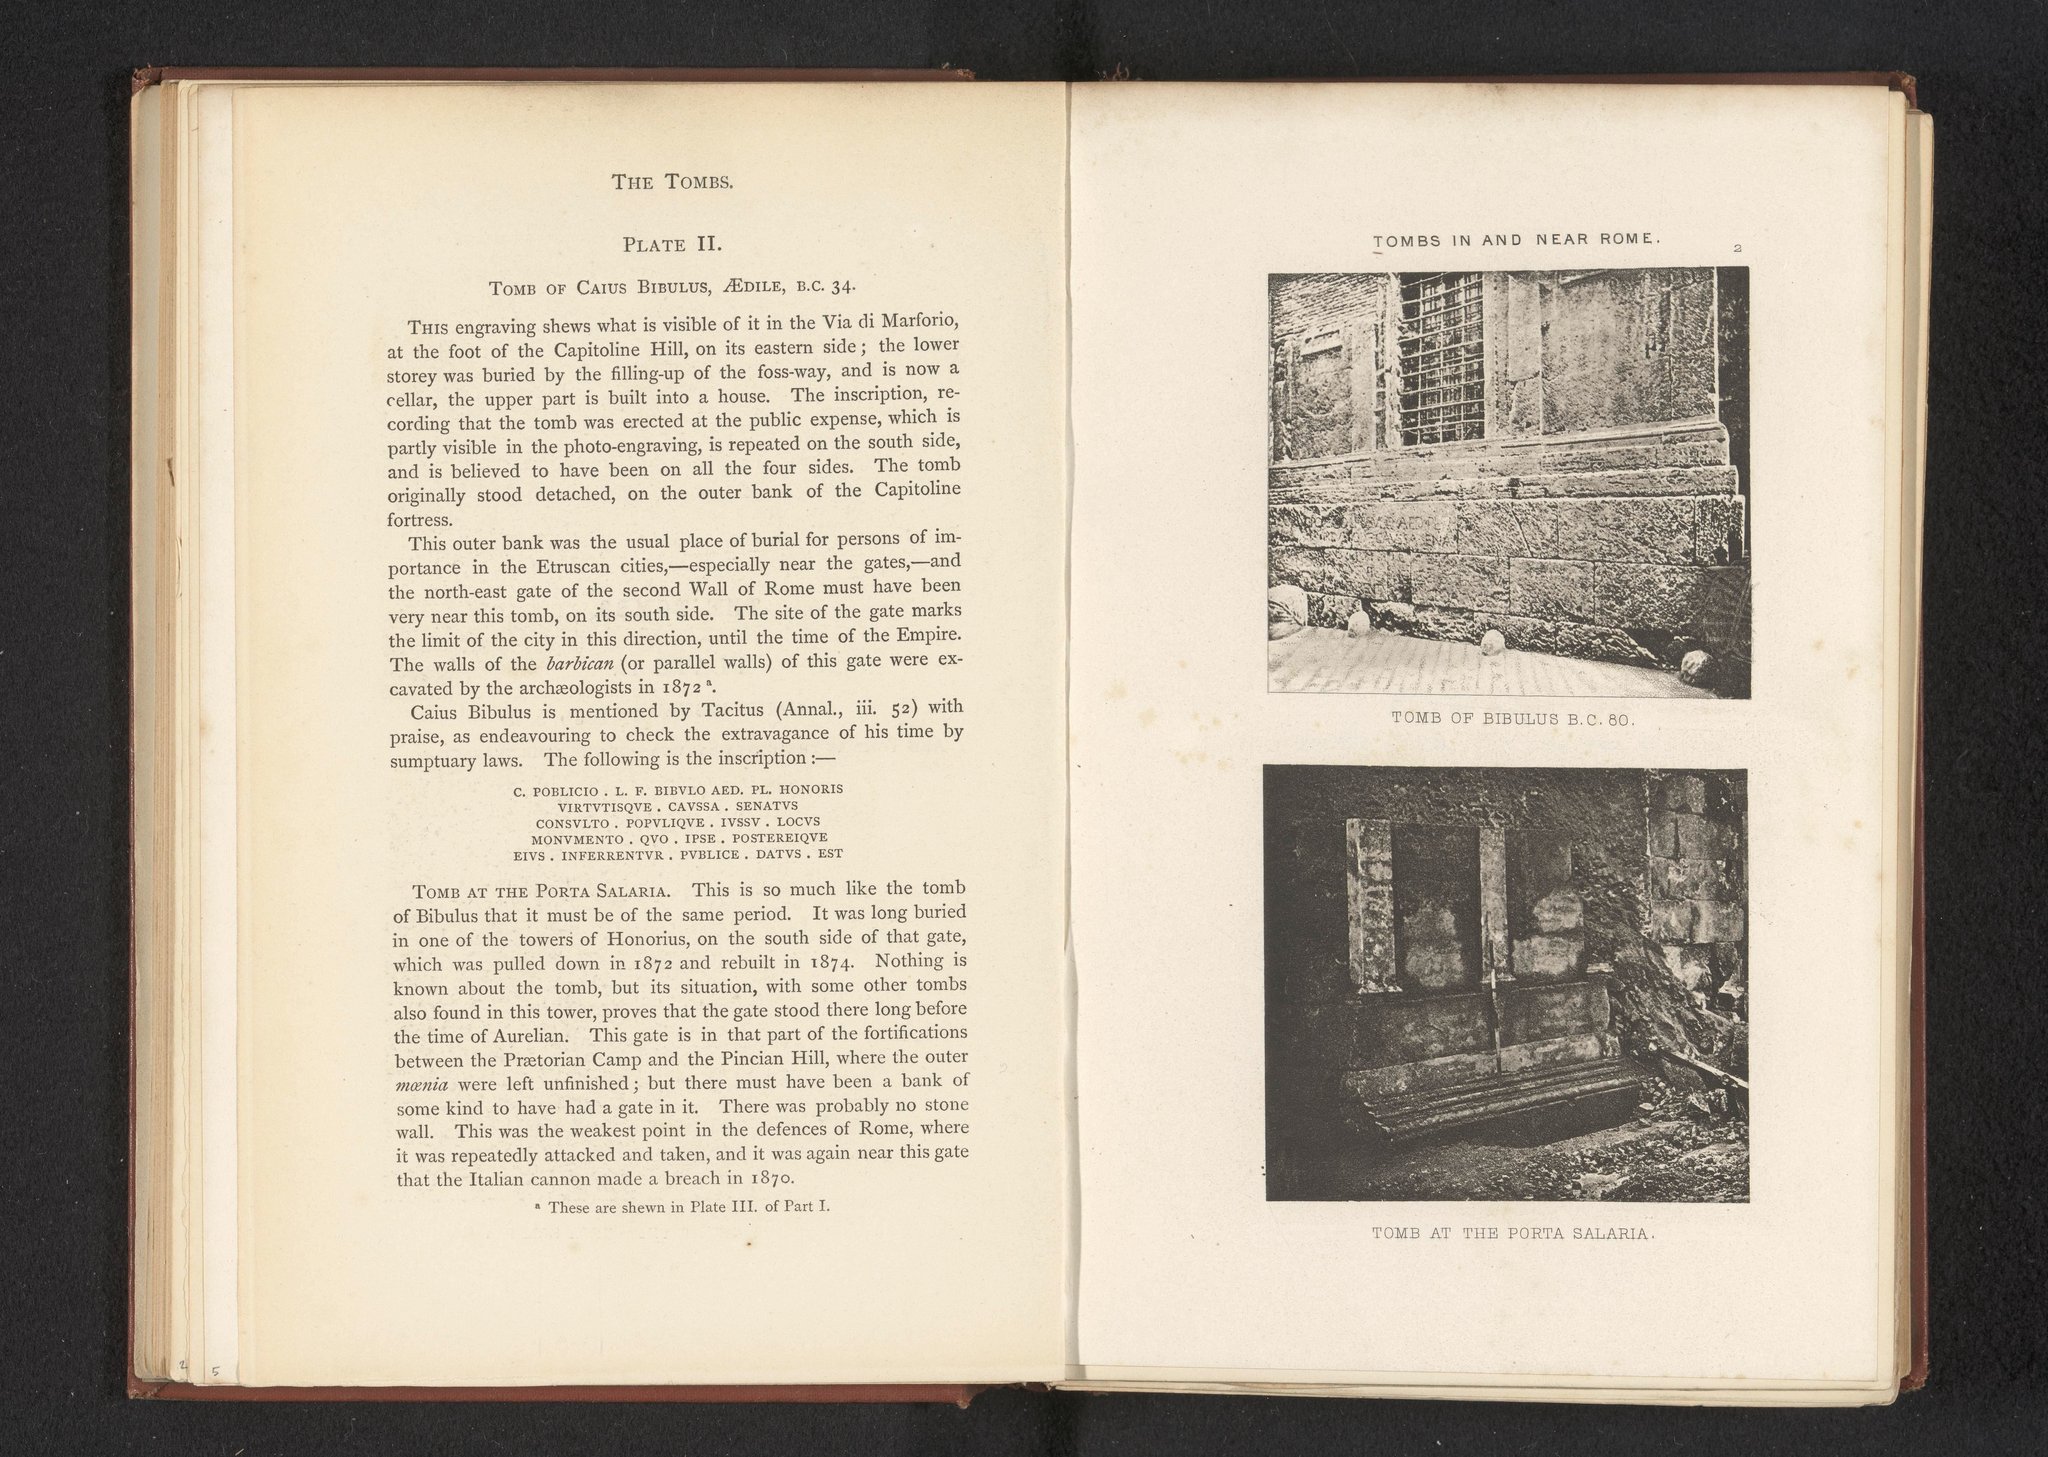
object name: photomechanical print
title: Tomb of Bibulus B.C. 80. Tomb at the Porta Salaria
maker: Anonymous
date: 1870-1877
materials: paper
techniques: photoaquatint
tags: grave, tomb, rome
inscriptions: number: ‘2’